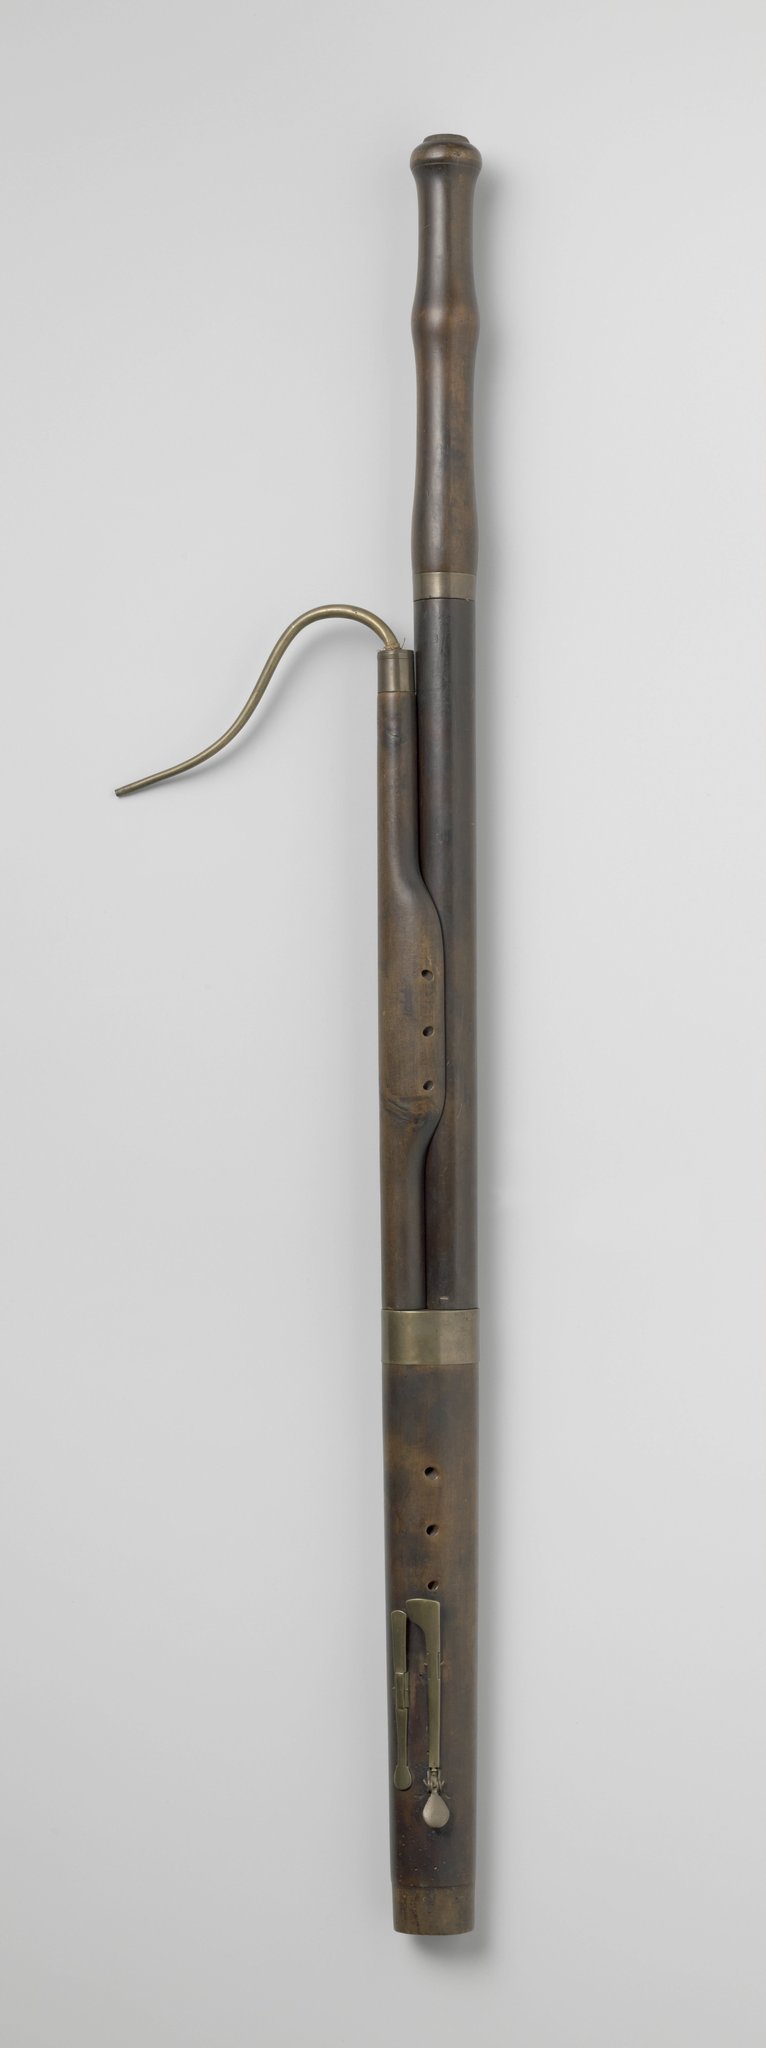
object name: bassoon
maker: johannes van de knikker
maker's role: musical instrument maker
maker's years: 1731-1815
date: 1780-1800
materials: copper, wood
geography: tilburg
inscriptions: stamp: ‘IVD/ KNIKKER’, stamp: ‘IVD/ KNIKKER/ TILBORGH’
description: Fagot van esdoornhout met vier koperen kleppen en met acht onbedekte gaten. Koperen "S" en koperen ringen waarvan de onderste ontbreekt.